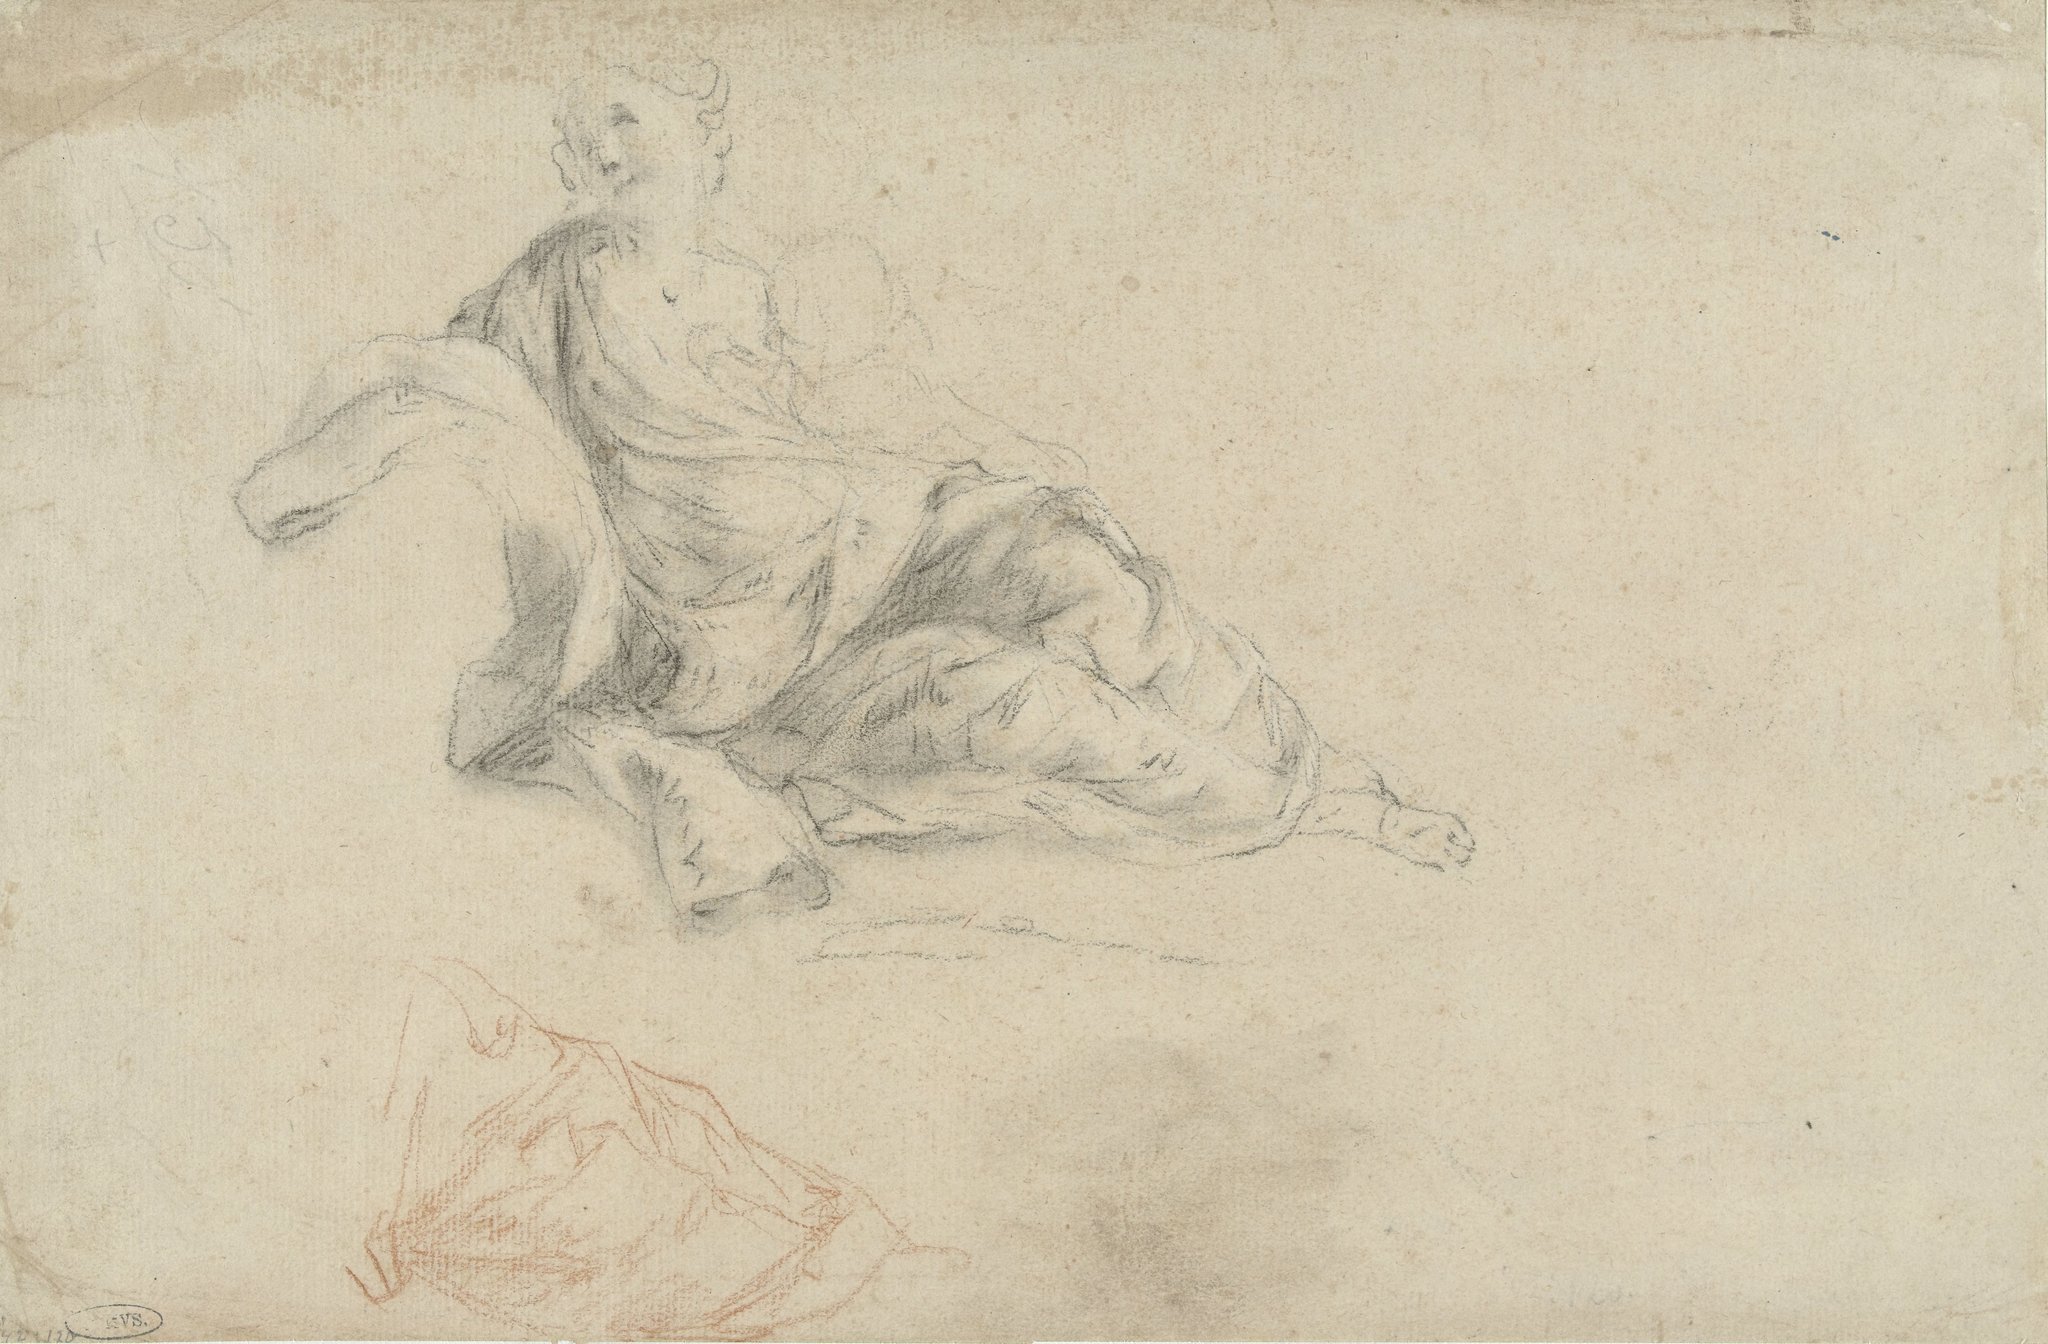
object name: drawing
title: Schetsen van een liggende vrouw met een kind aan de borst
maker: Anonymous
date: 1700-1800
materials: chalk, paper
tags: nursing, suckling, sitting on the ground - aa - female human figure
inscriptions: collector's mark: Lugt 2228